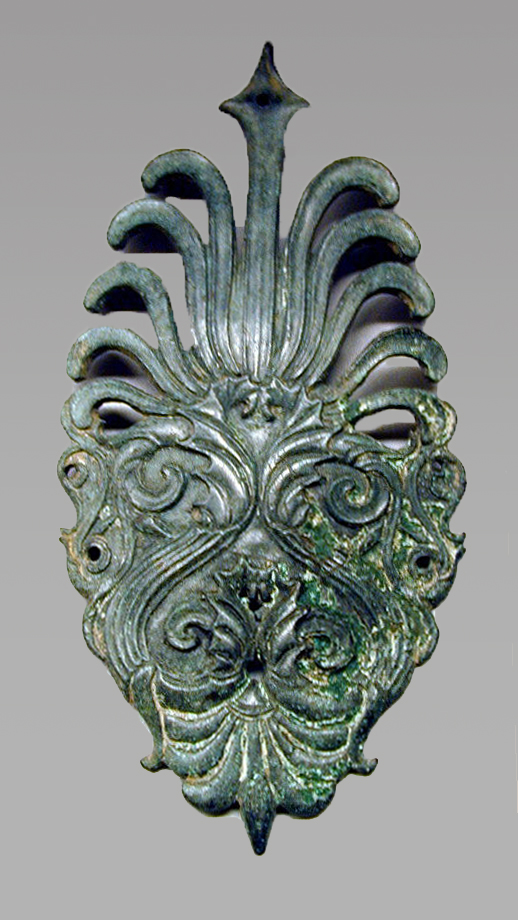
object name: appliqué in the form of a foliate composition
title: Bronze decorative appliqué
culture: greek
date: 350-301 BCE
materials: bronze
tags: palmettes